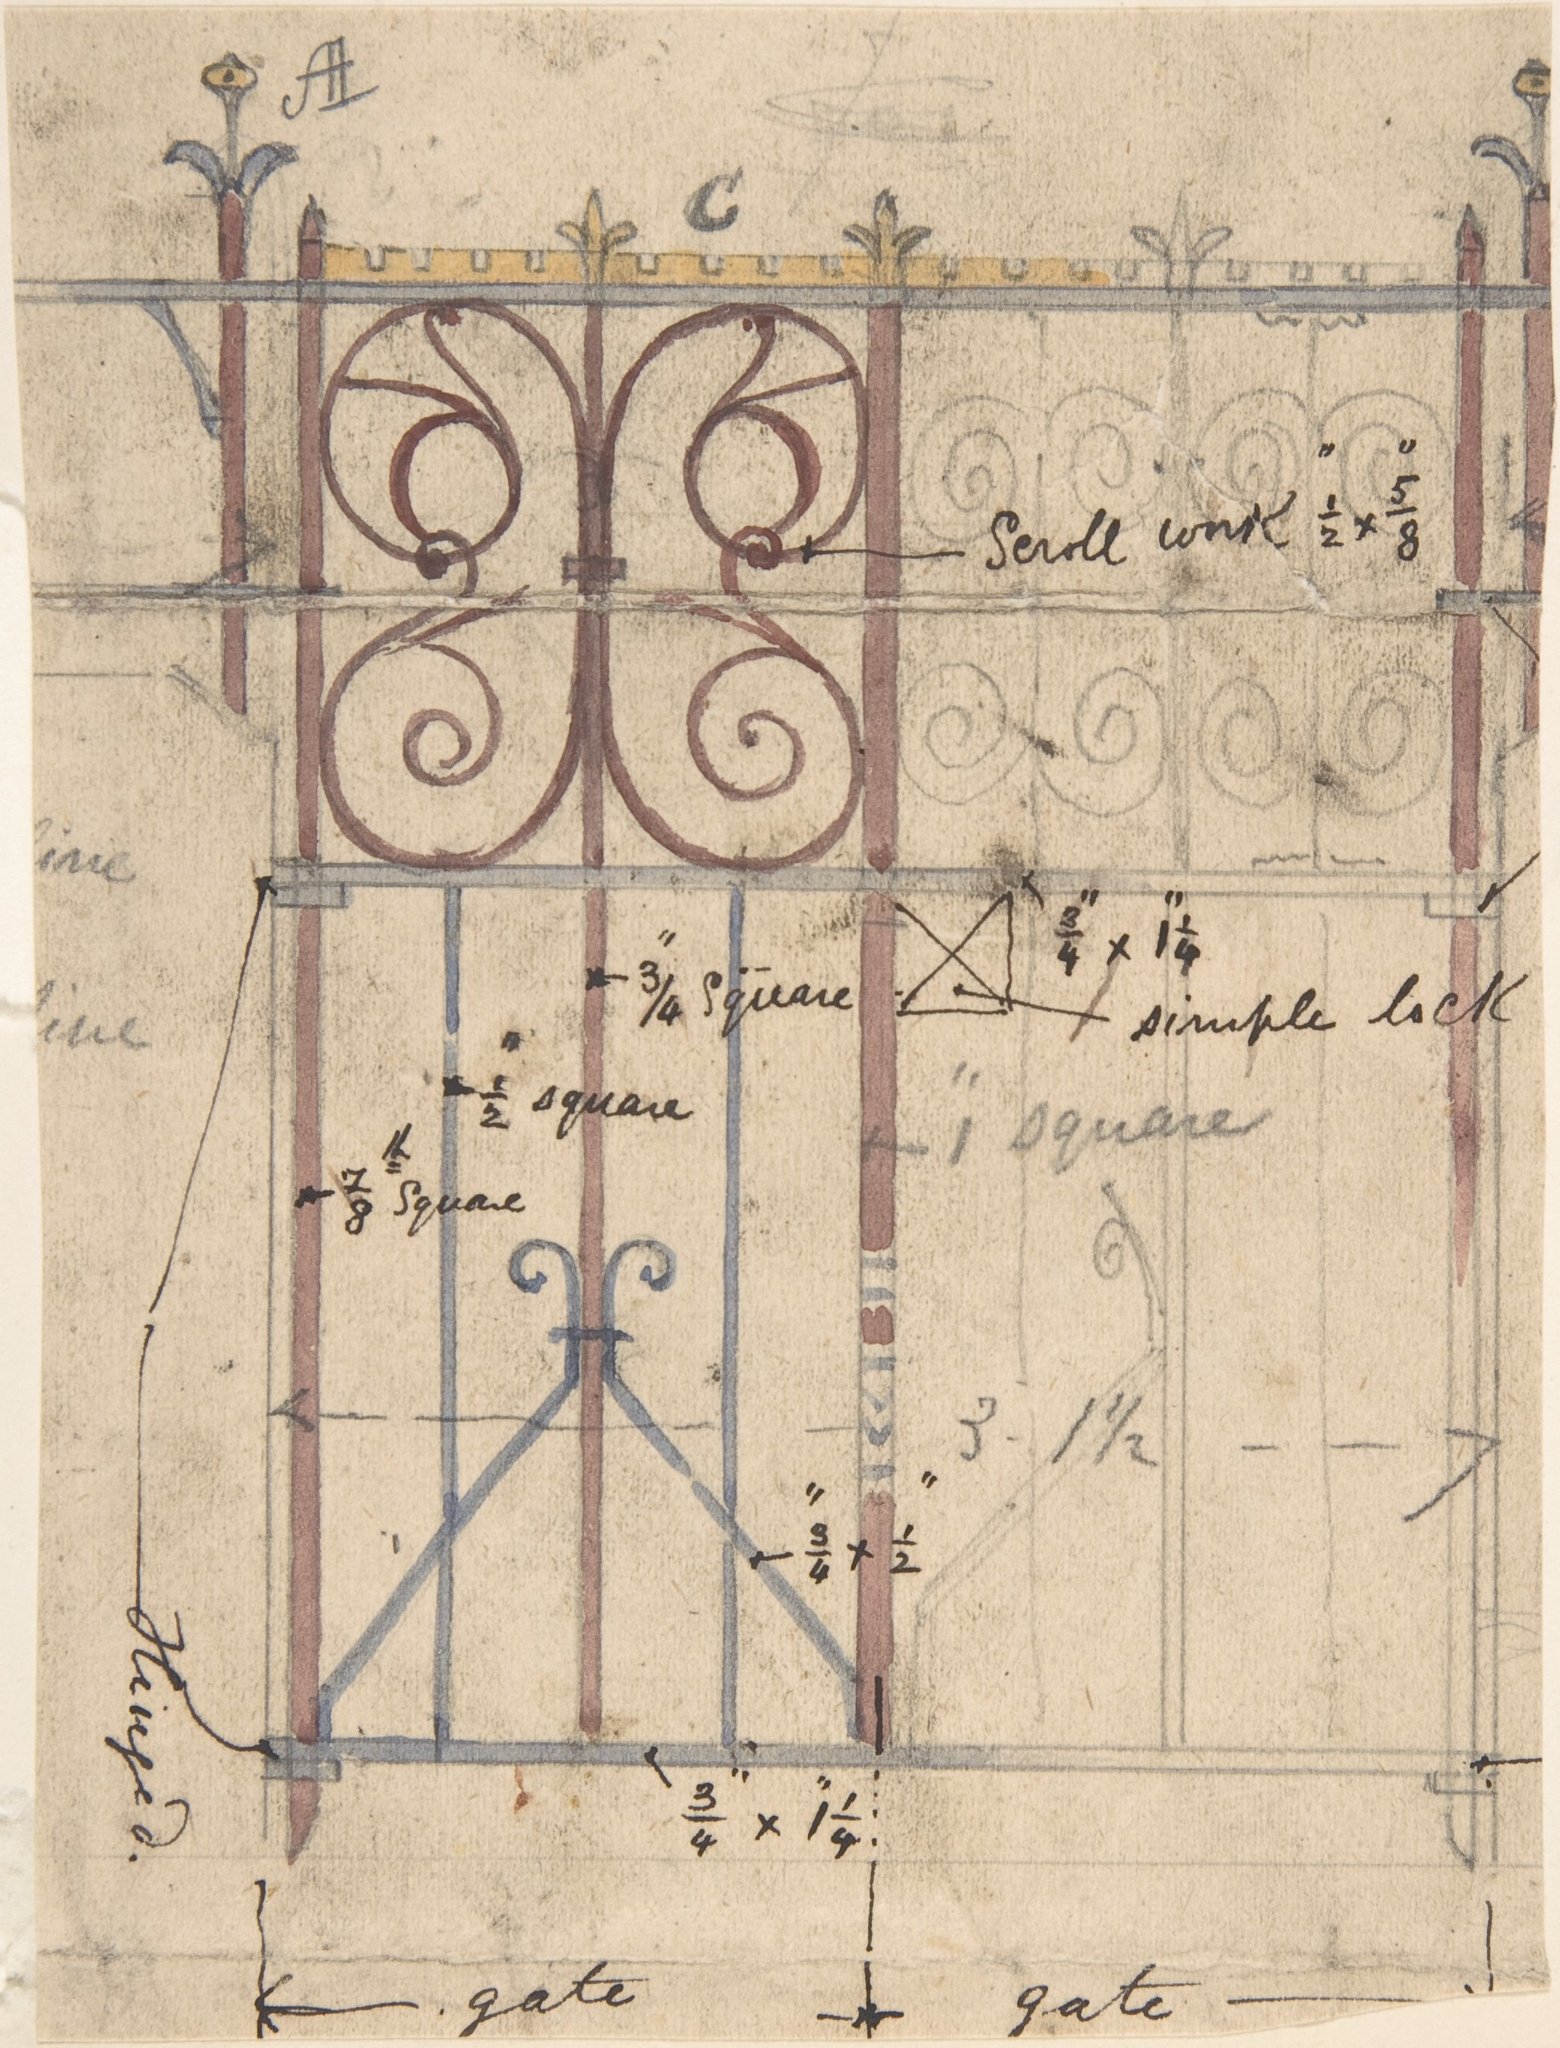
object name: drawing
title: Design for a Church Gate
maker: richardson ellson & co.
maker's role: artist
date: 1880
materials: ink, watercolor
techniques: brush, pen, wash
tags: gates